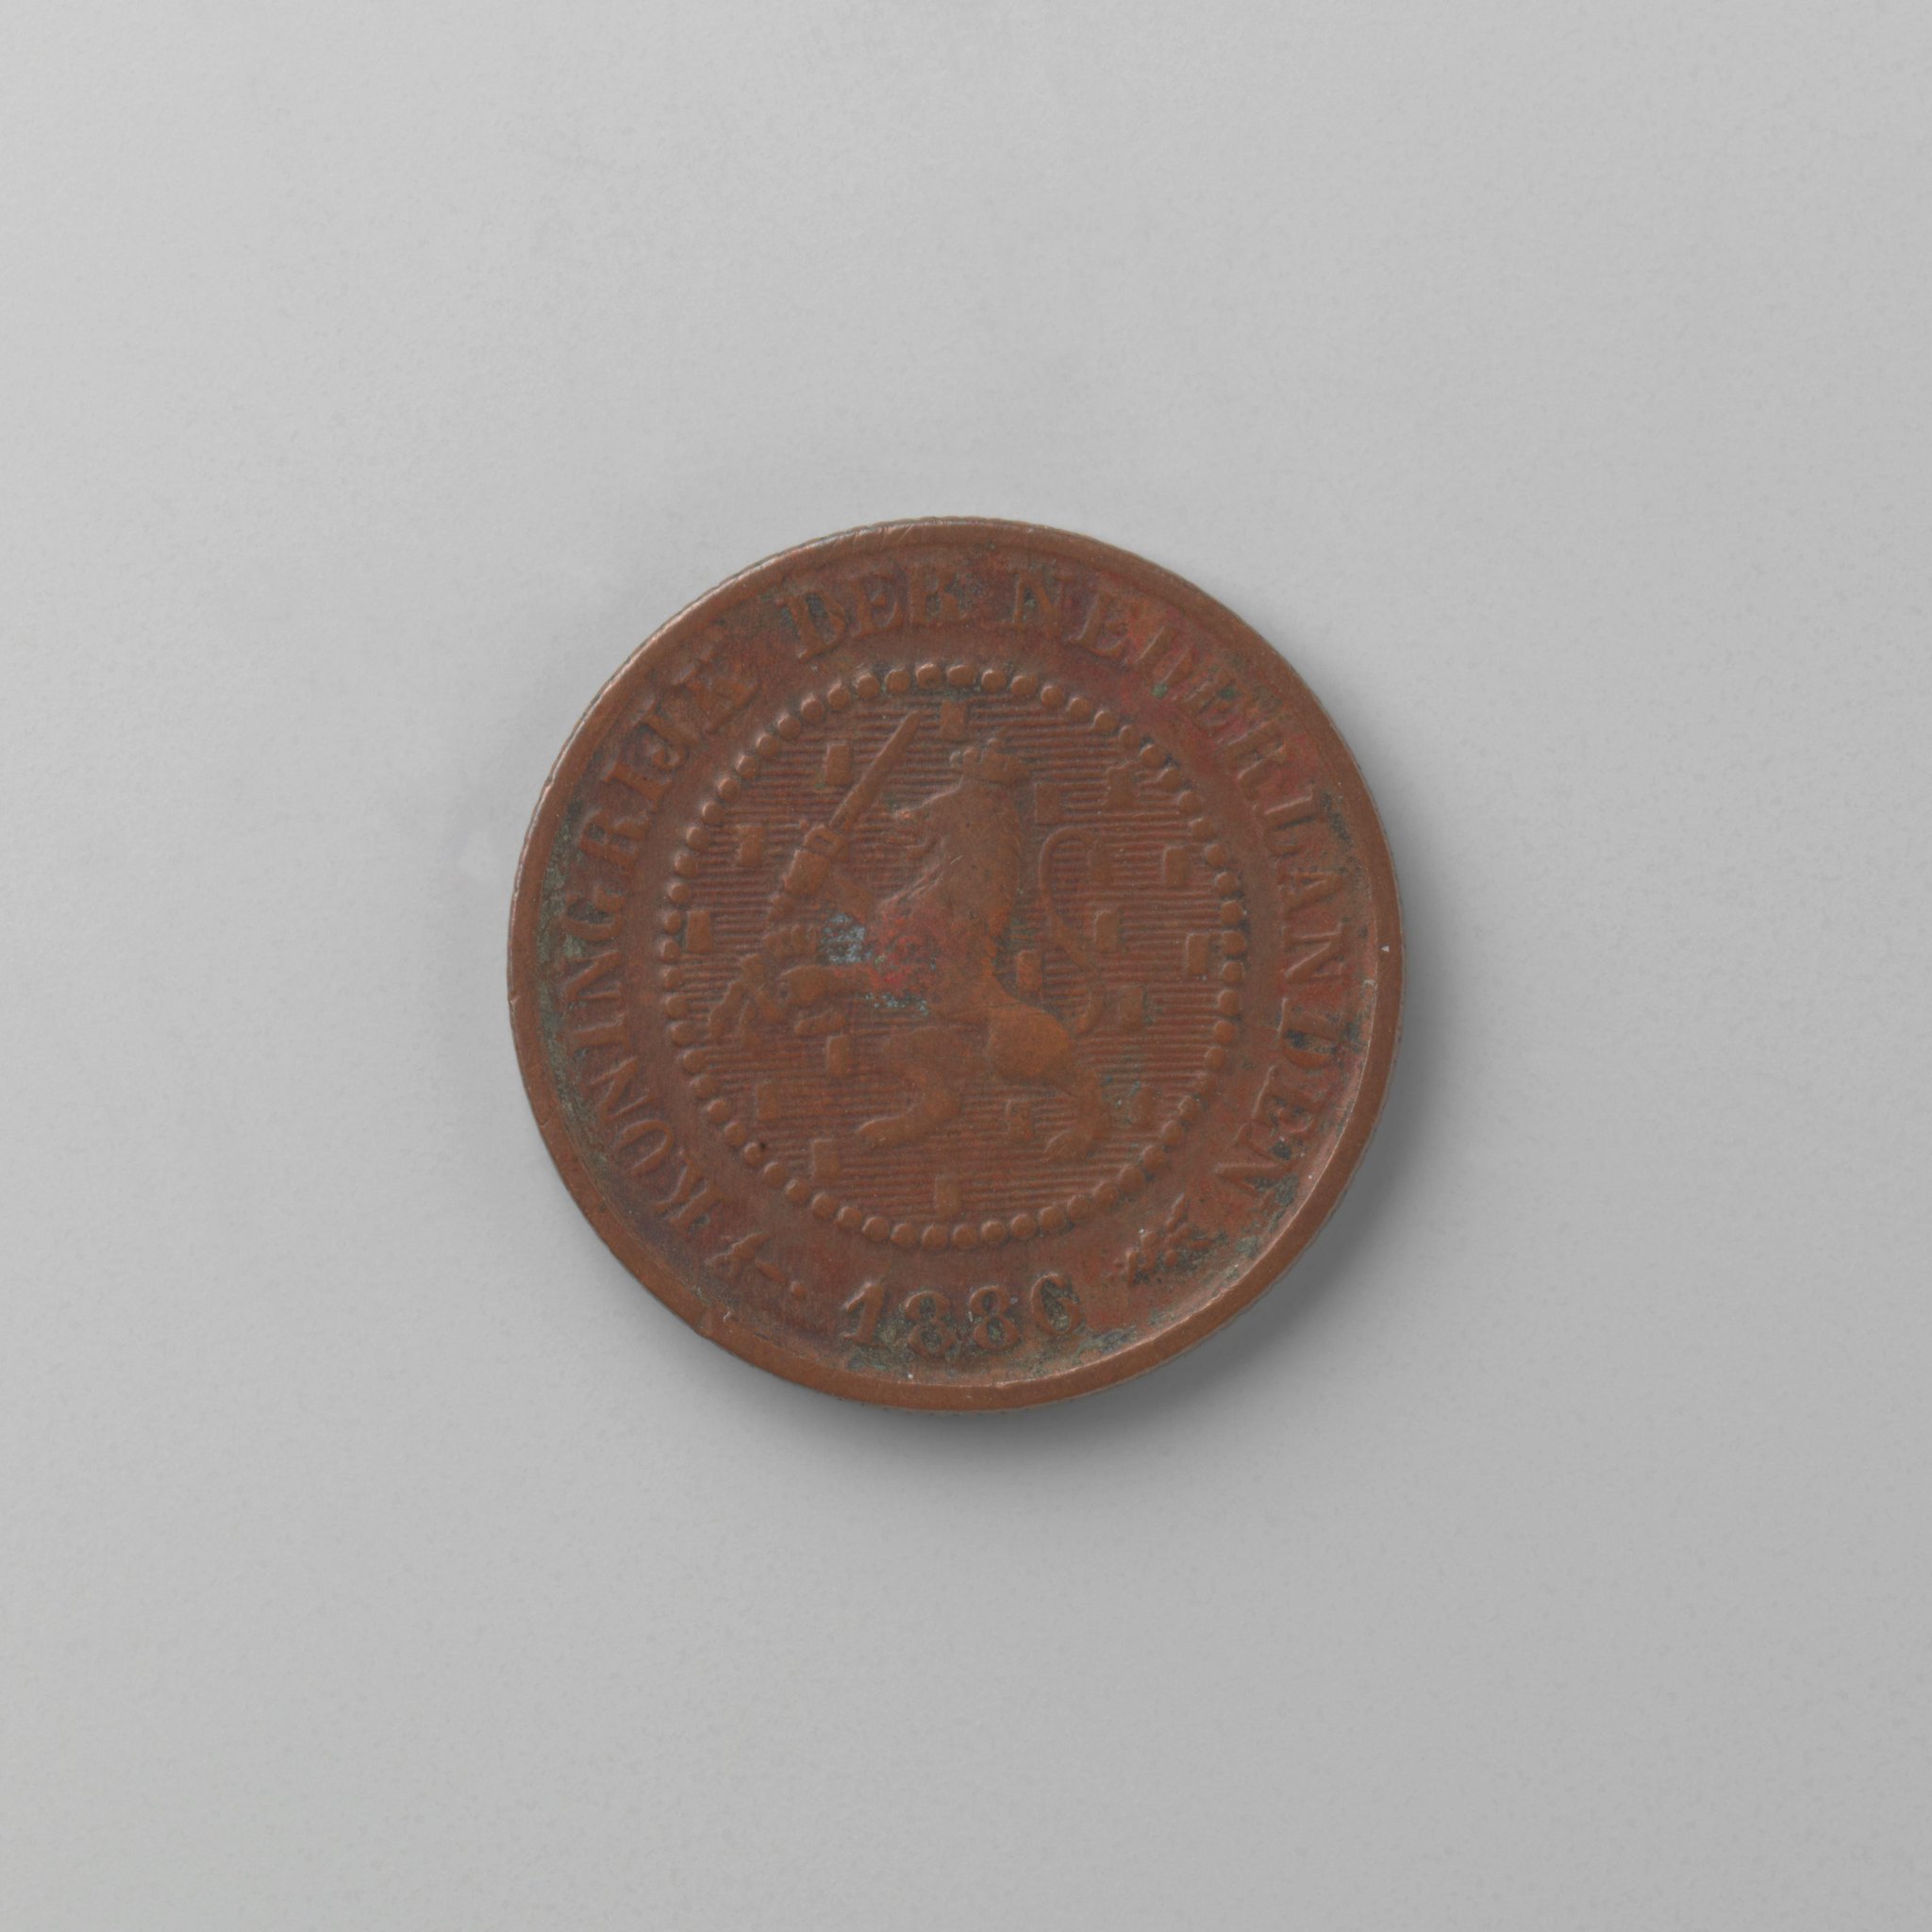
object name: coin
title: Nederlandse ½ cent, 1886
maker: willem iii (koning der nederlanden)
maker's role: koning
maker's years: 1817-1890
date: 1886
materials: bronze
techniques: striking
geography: utrecht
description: Bronzen munt. Voorzijde: in een veld rijkswapen. Jaartal onderaan in omschrift. Keerzijde: binnen twee samengebonden oranjetakken waarde-aanduiding ½ cent. Kartelrand.